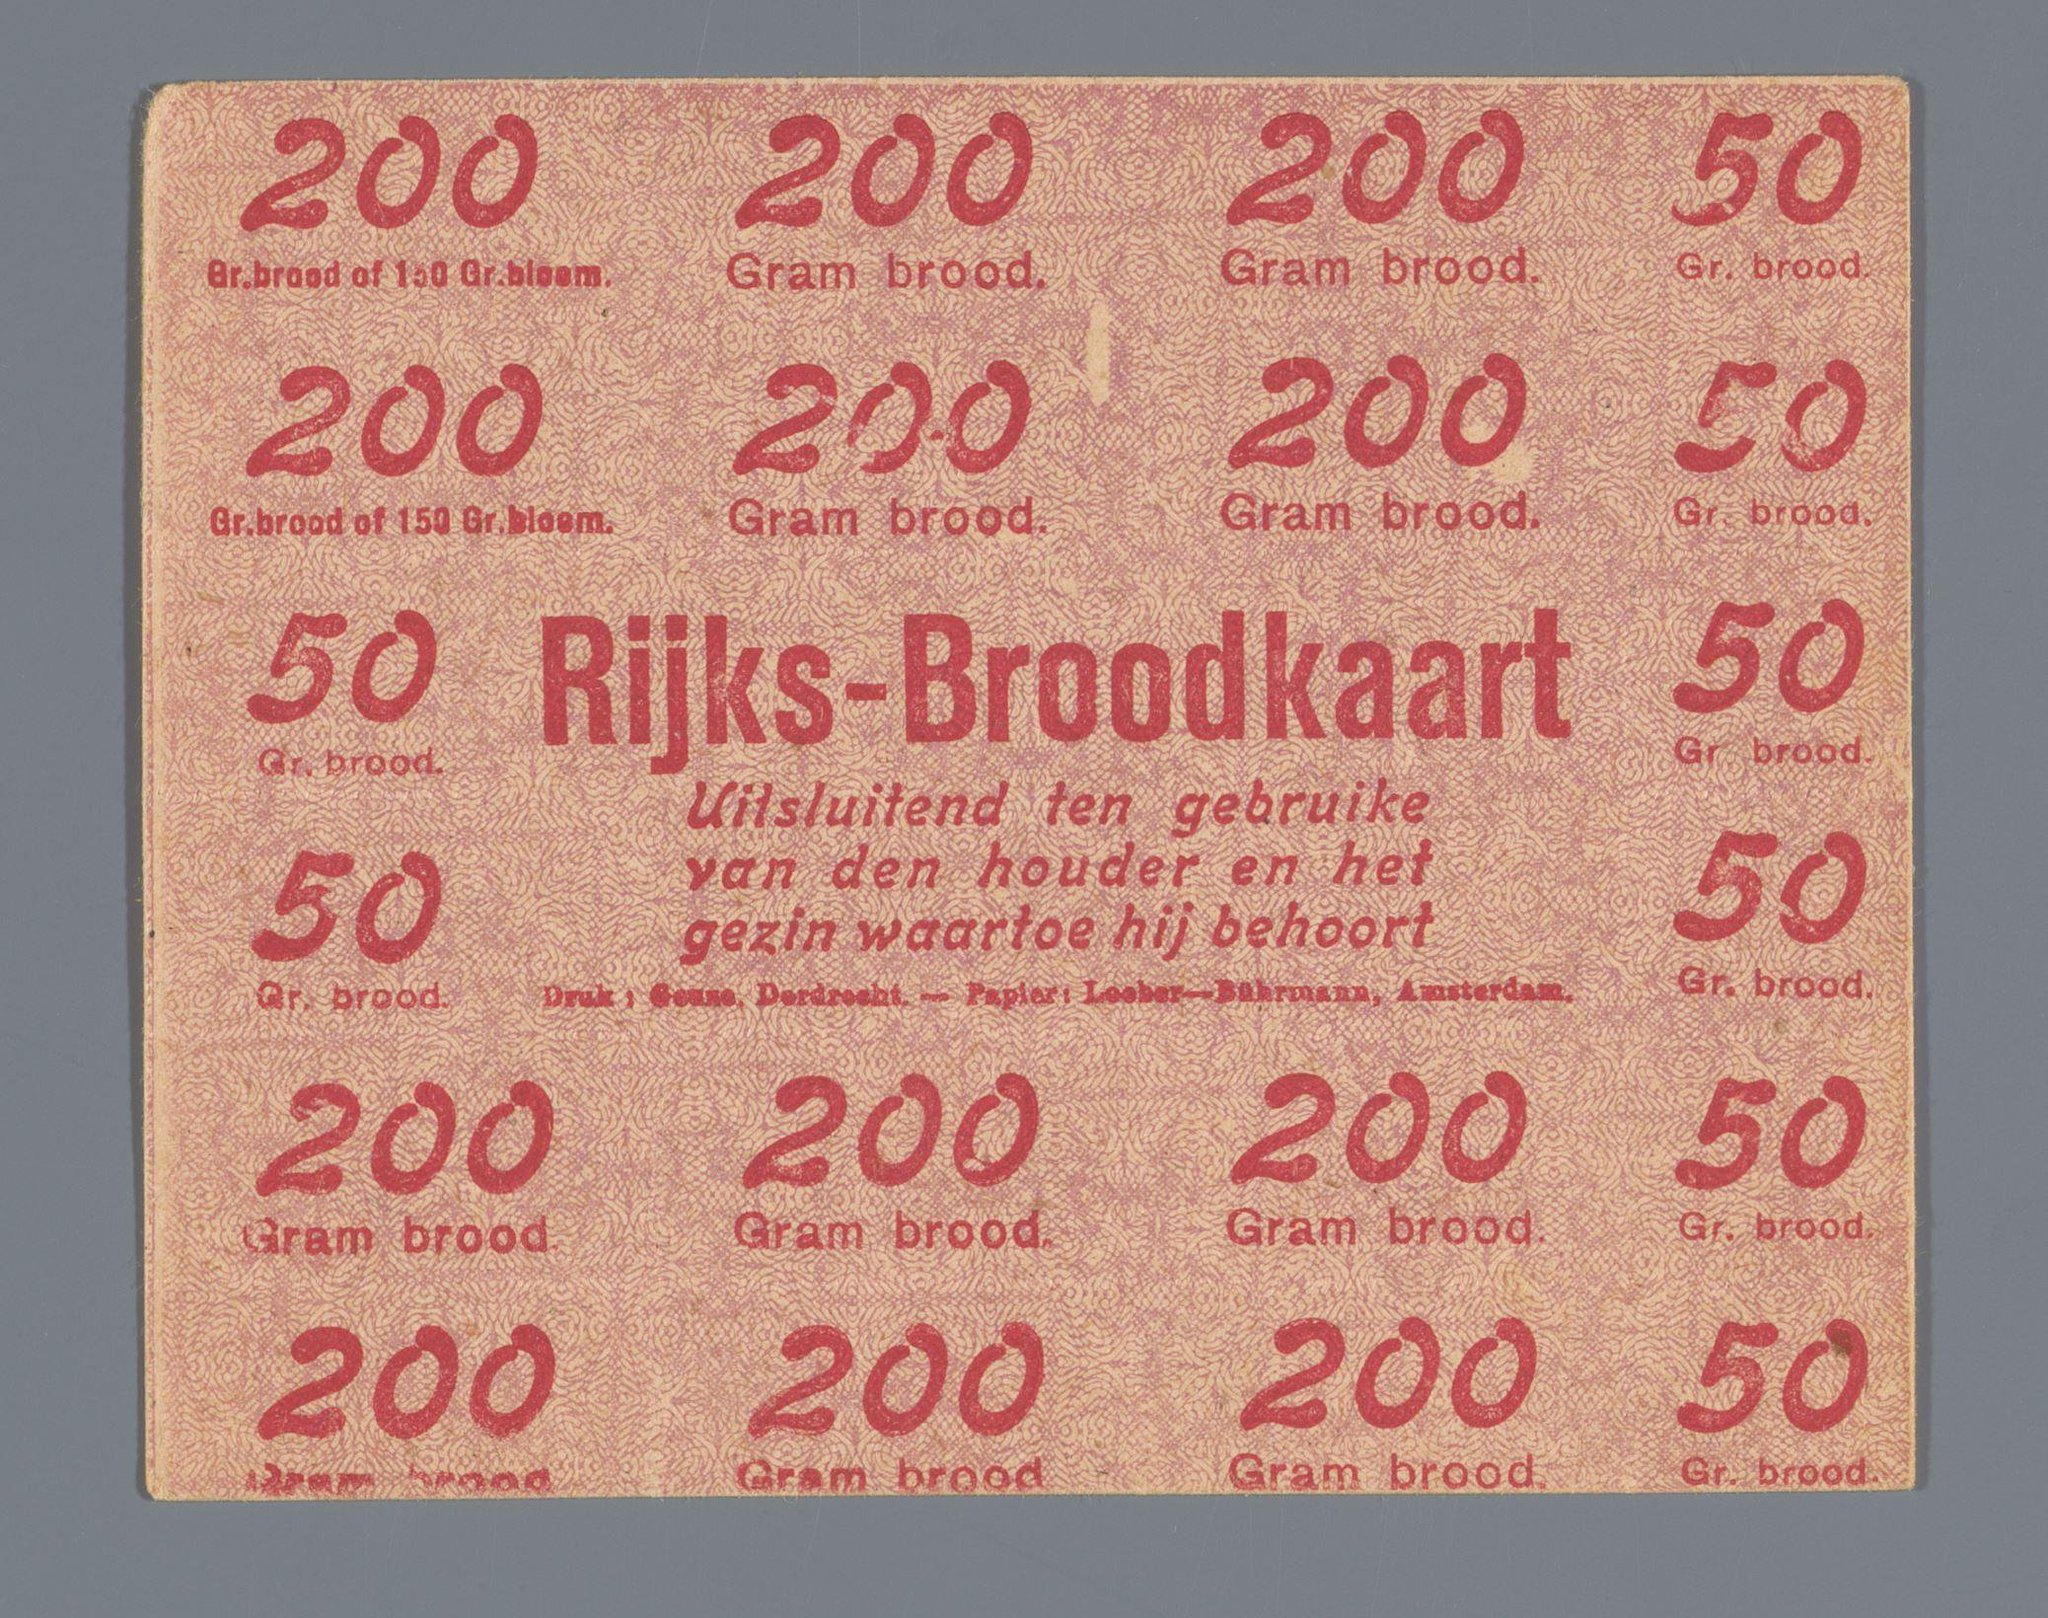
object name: ration coupon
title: Rijksbroodkaart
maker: gouze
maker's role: printer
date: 1918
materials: paper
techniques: printing, writing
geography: dordrecht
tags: eerste wereldoorlog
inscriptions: : ‘RIJKS-BROODKAART / 200 / Gram Brood / 50 GR. brood’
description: Rood bedrukte bonkaart met rose ondergrond; hierop opschriften. Bon werd gebruikt om brood te verkrijgen.